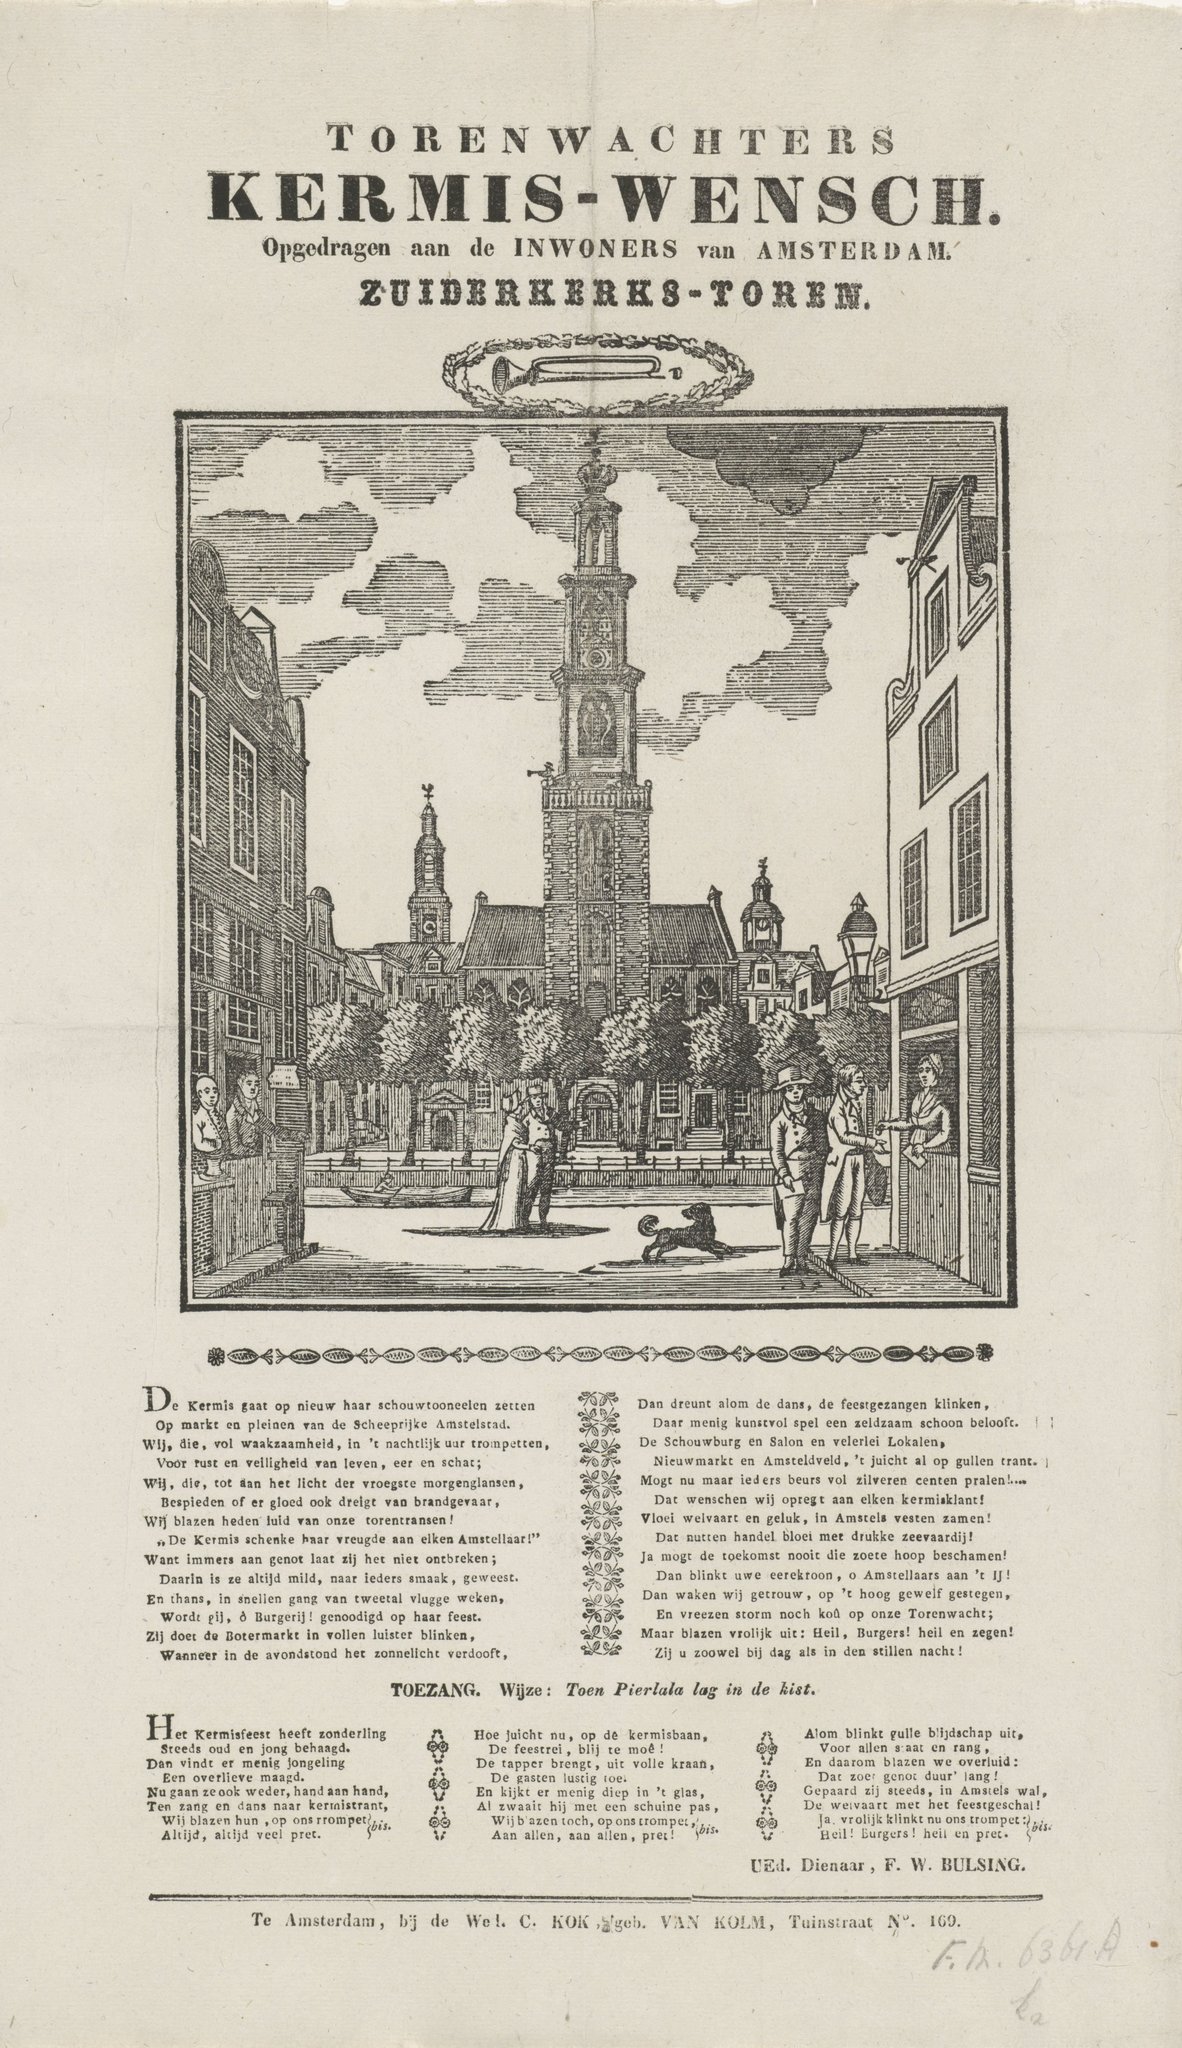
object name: print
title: Torenwachters kermis-wensch (...) Zuiderkerks-toren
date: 1840-1870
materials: paper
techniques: letterpress printing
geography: amsterdam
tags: tower sentry, street, amsterdam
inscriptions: collector's mark: Lugt 2228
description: Kermisprent van de torenwachter van de Amsterdamse Zuiderkerk, ca. 1840-1870. Gezicht op de Westerkerk te Amsterdam, twee mannen halen aan de huizen geld op. Onderaan een vers in twee kolommen en een lied in drie verzen. Van de torenwachter: F.W. Bulsing.